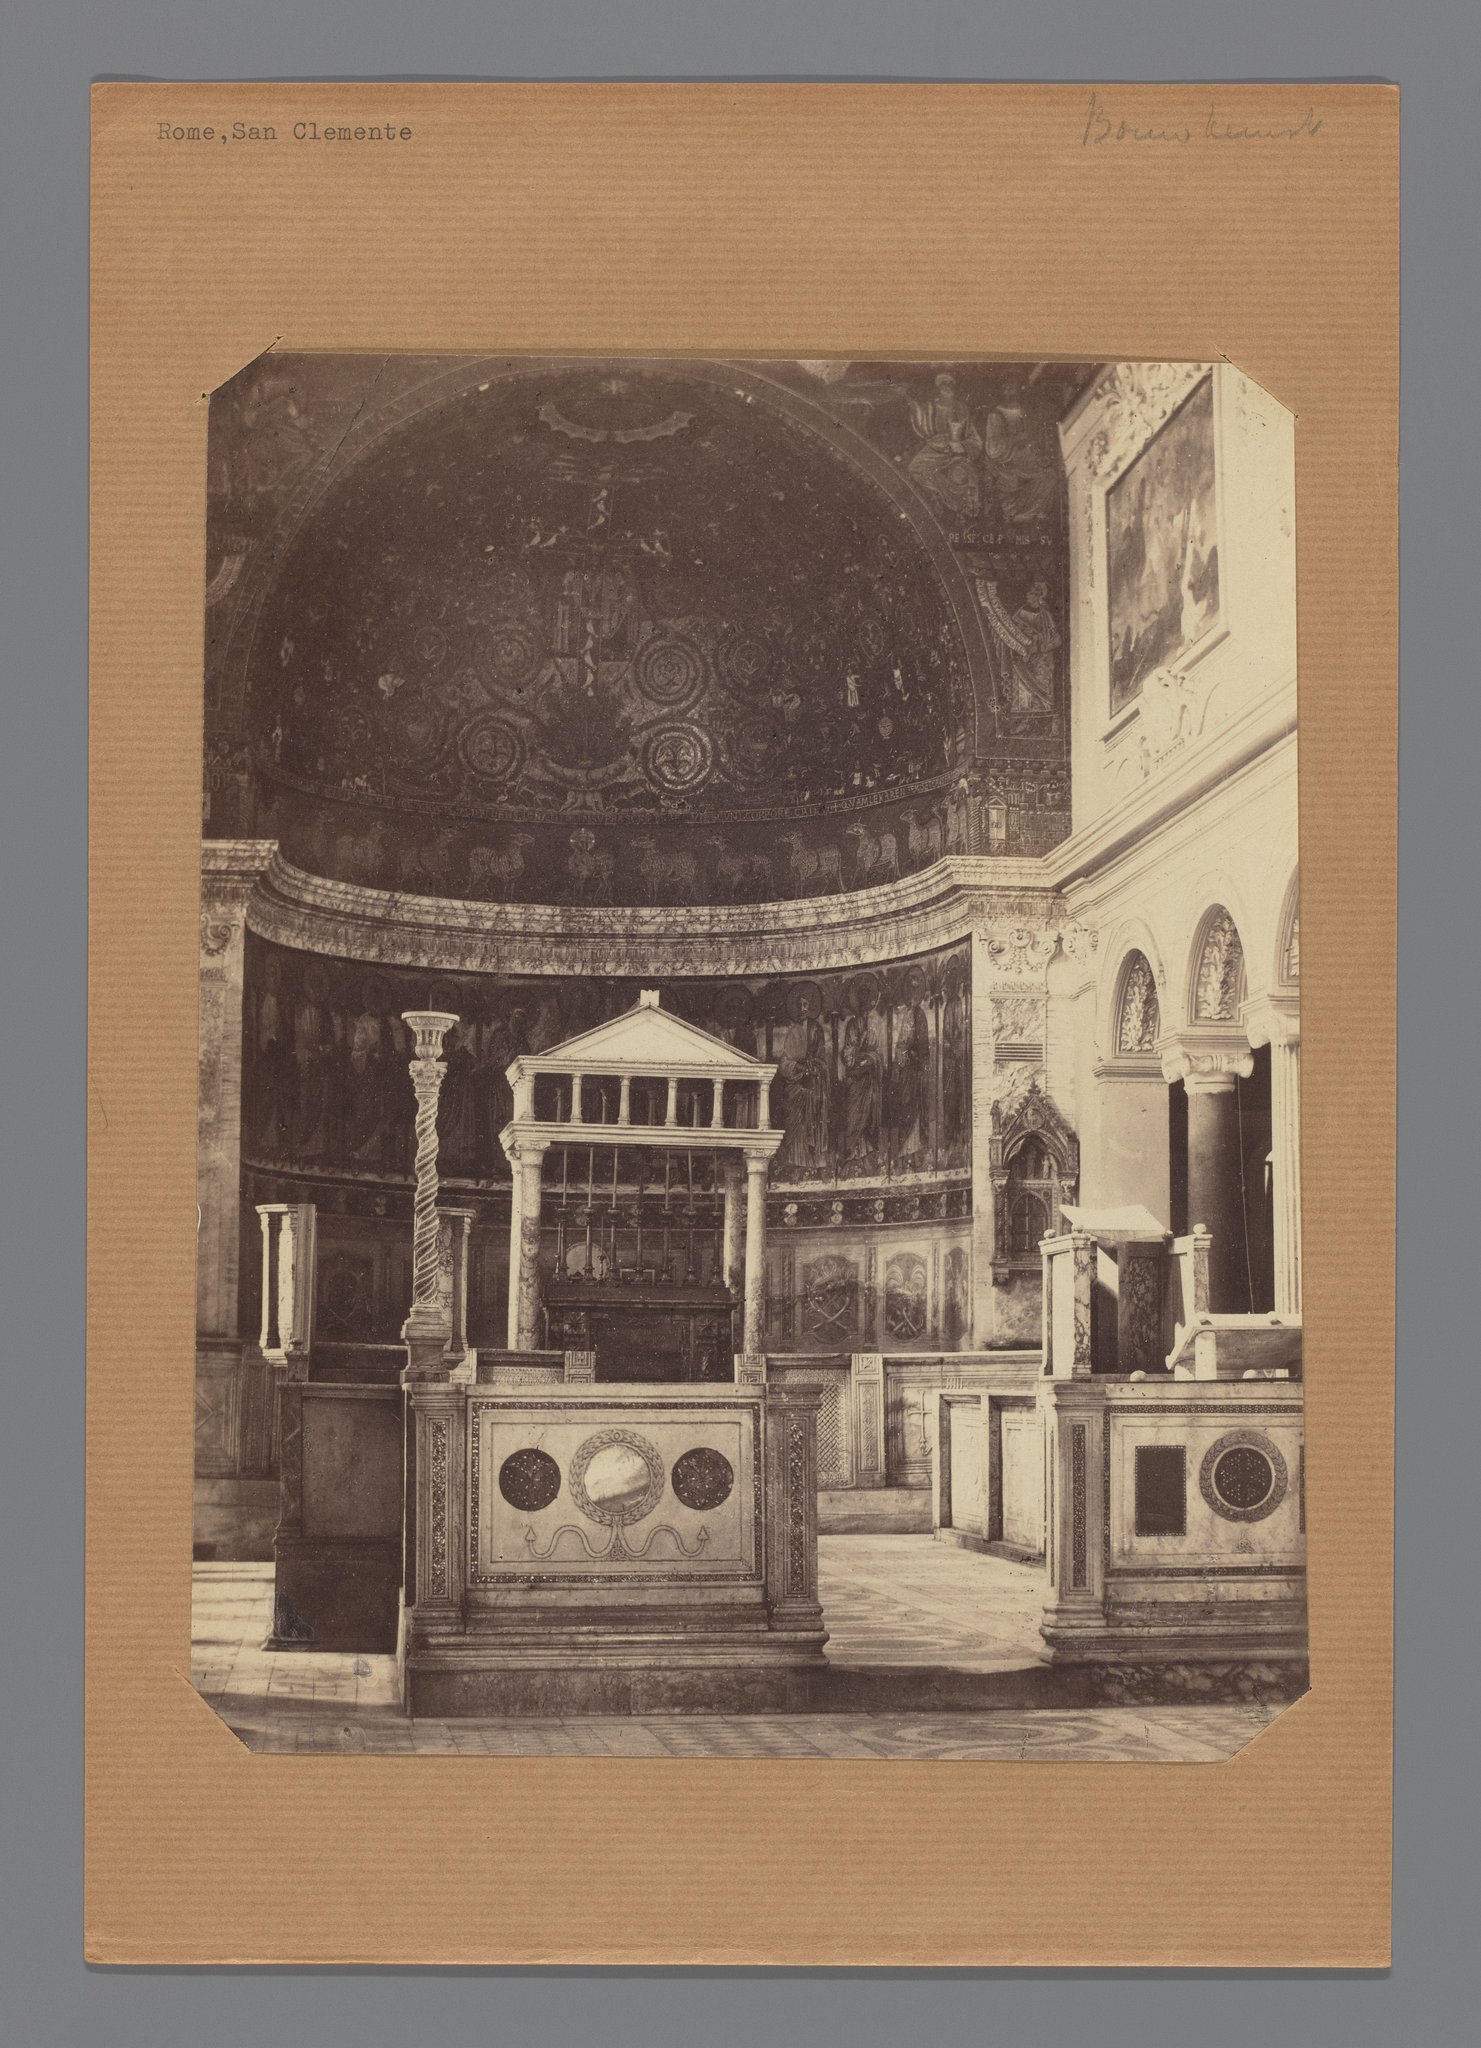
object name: photograph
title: San Clemente, Rome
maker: Anonymous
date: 1850-1899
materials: paper, photographic support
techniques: albumen print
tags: san clemente